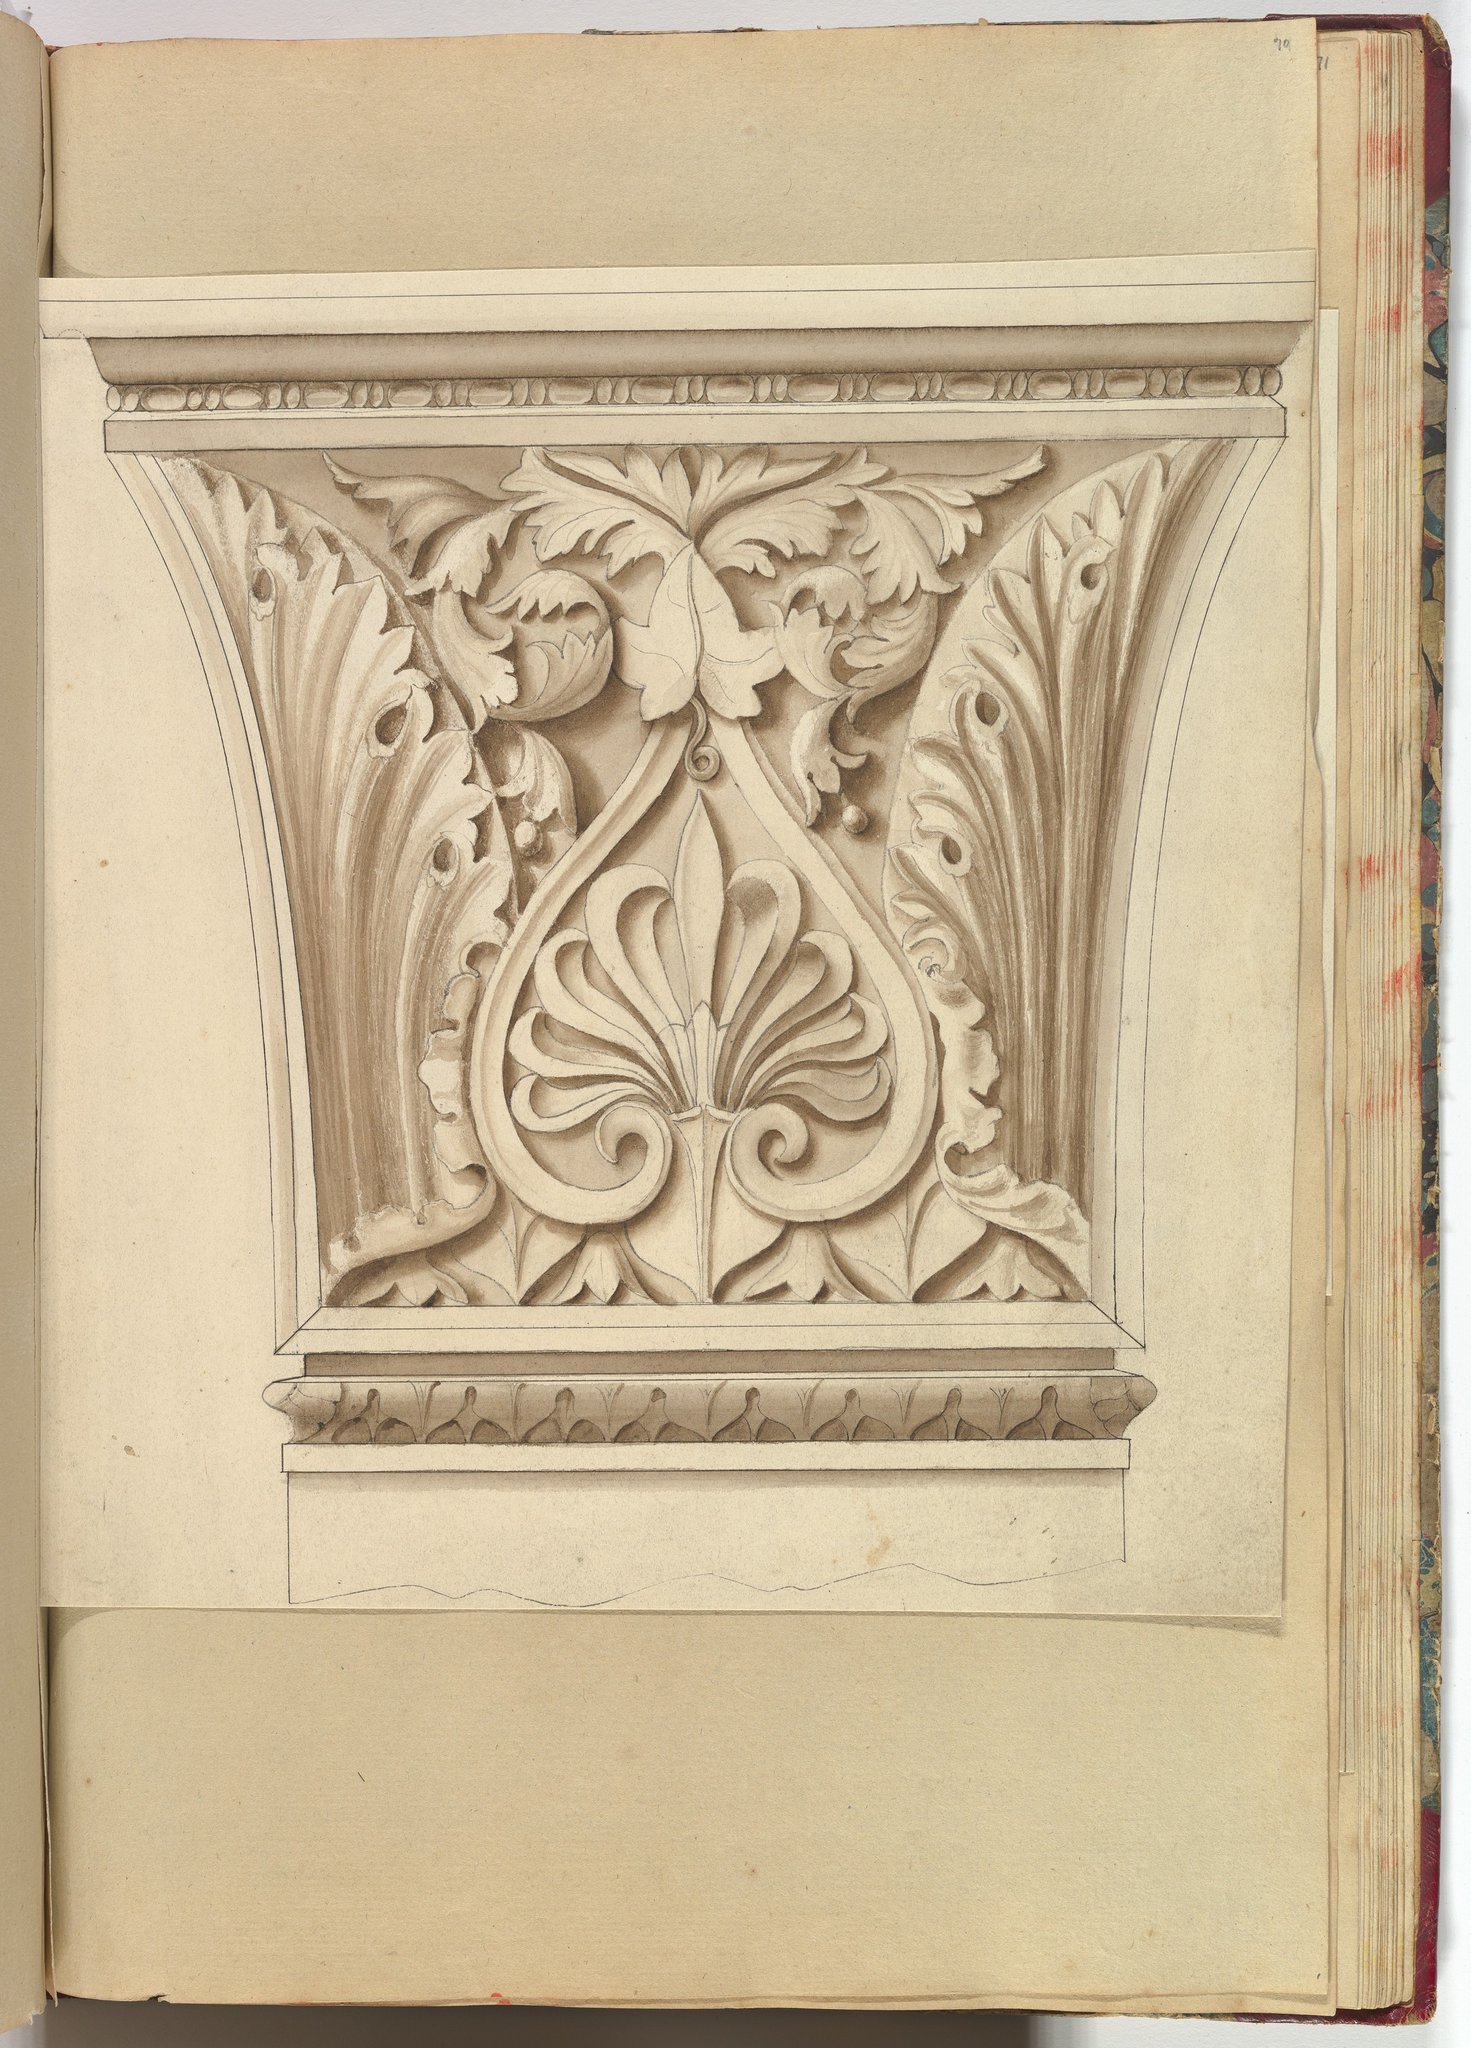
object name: drawing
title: Capital of a Column with Anthemion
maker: alfred henry forrester [alfred crowquill]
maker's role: artist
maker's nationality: british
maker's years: 1804-1872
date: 1845-1870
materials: ink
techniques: brush, pen, wash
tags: capitals